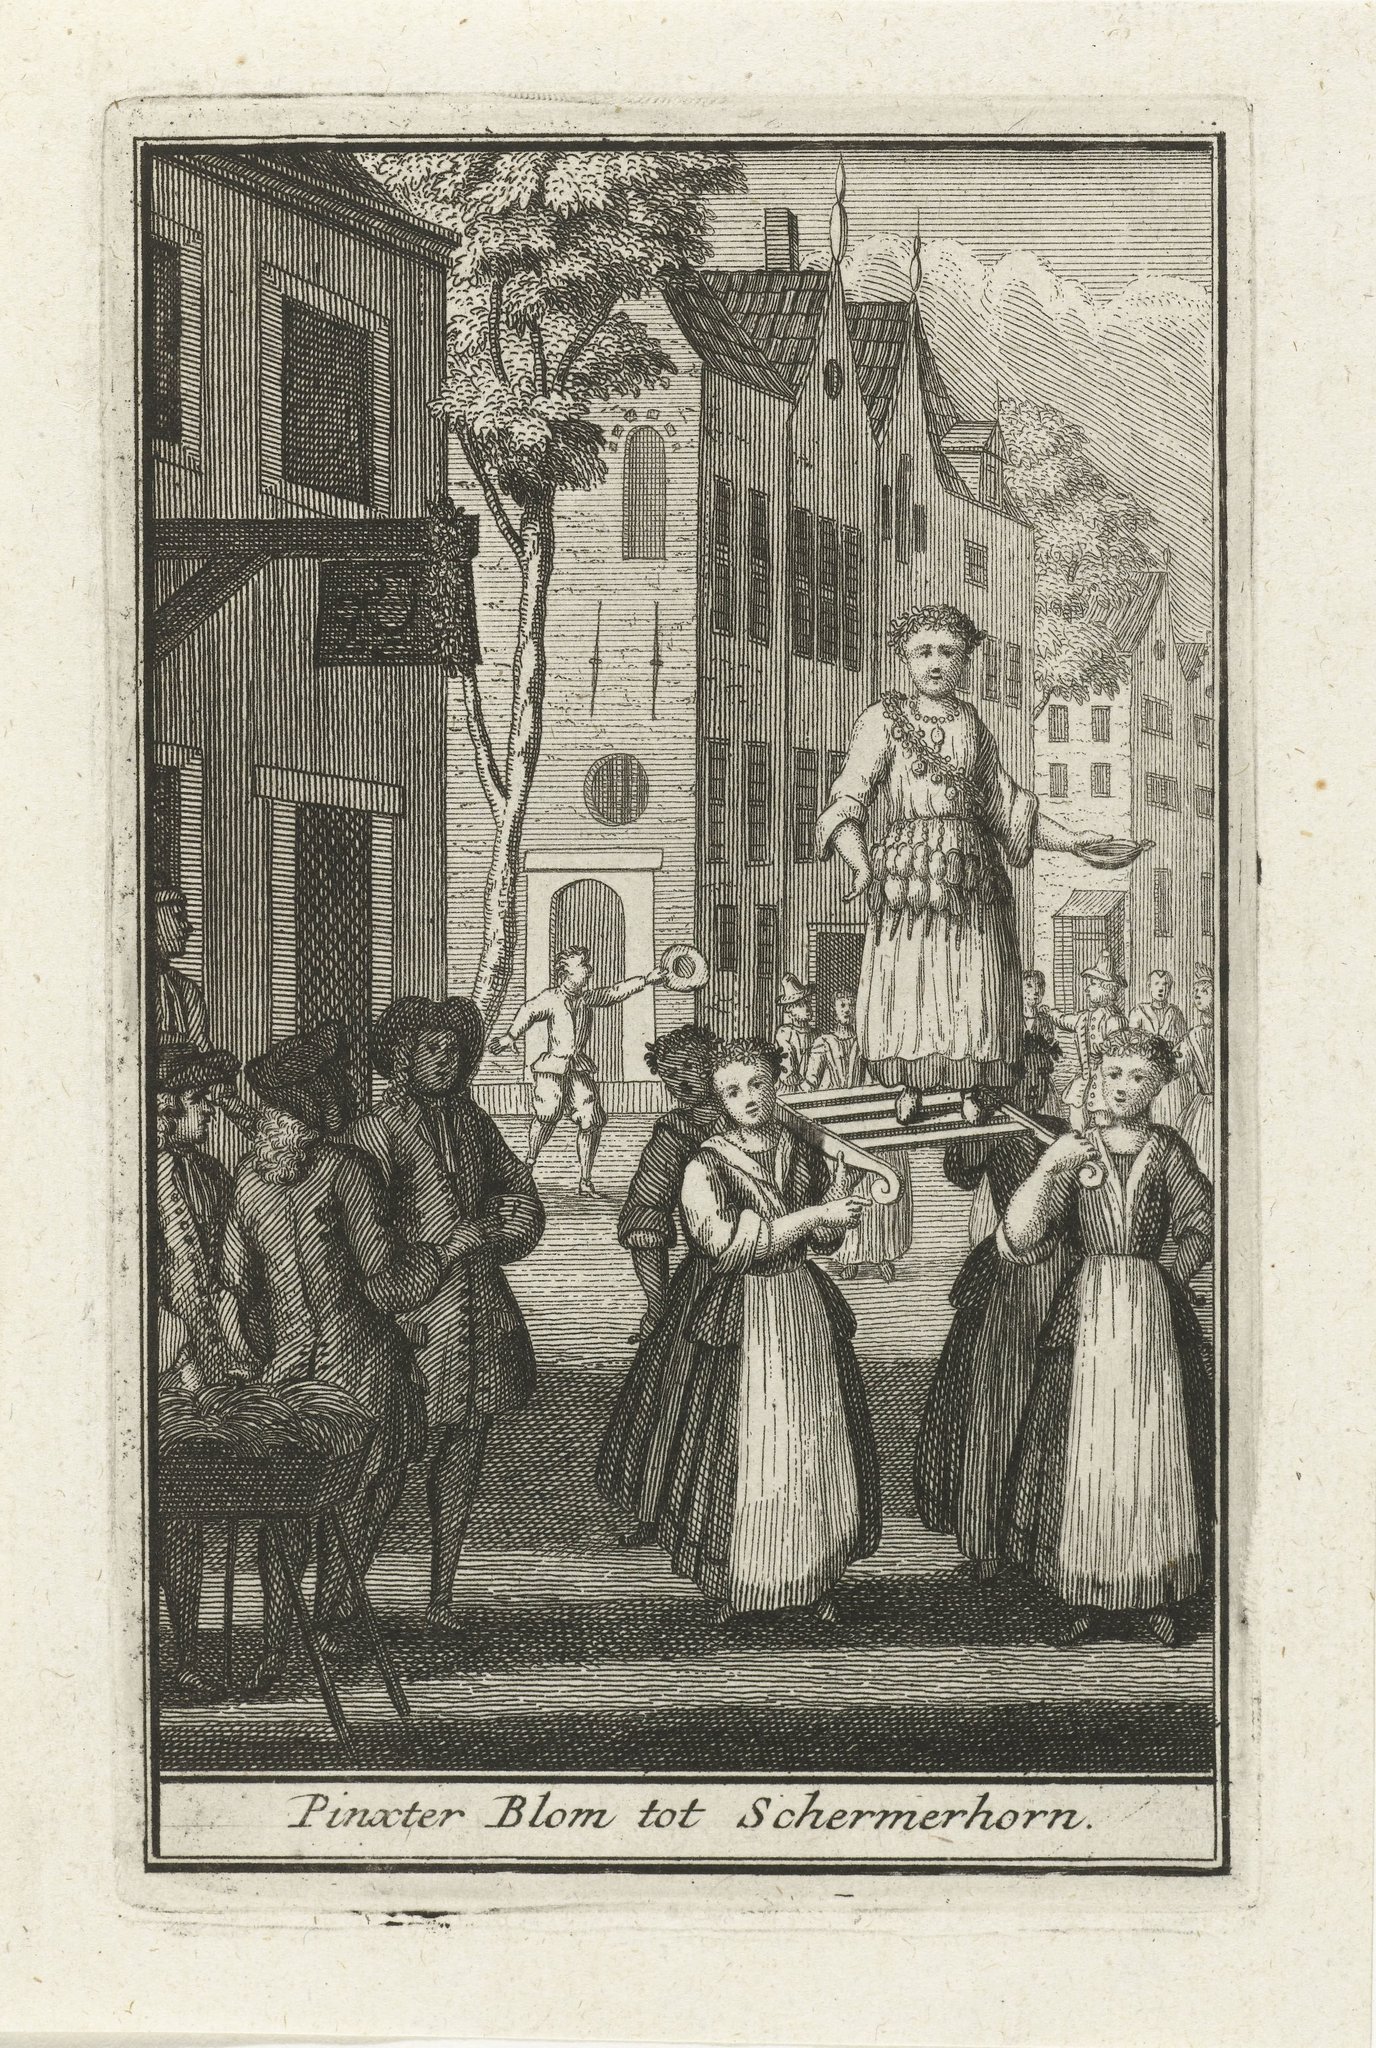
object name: book illustration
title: Pinster Blom tot Schermerhorn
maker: abraham zeeman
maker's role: print maker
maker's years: 1695-1754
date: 1732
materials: paper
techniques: engraving, etching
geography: amsterdam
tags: pentecost, whitsunday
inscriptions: collector's mark: Lugt 2228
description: Prent ook gebruikt in: Bruins, Claas. Noordhollandsche Arkadia verrykt met aantekeningen van den Heere Gerrit Schoemaker en verciert met printverbeeldingen. Amsterdam: Evert Visscher, 1732.